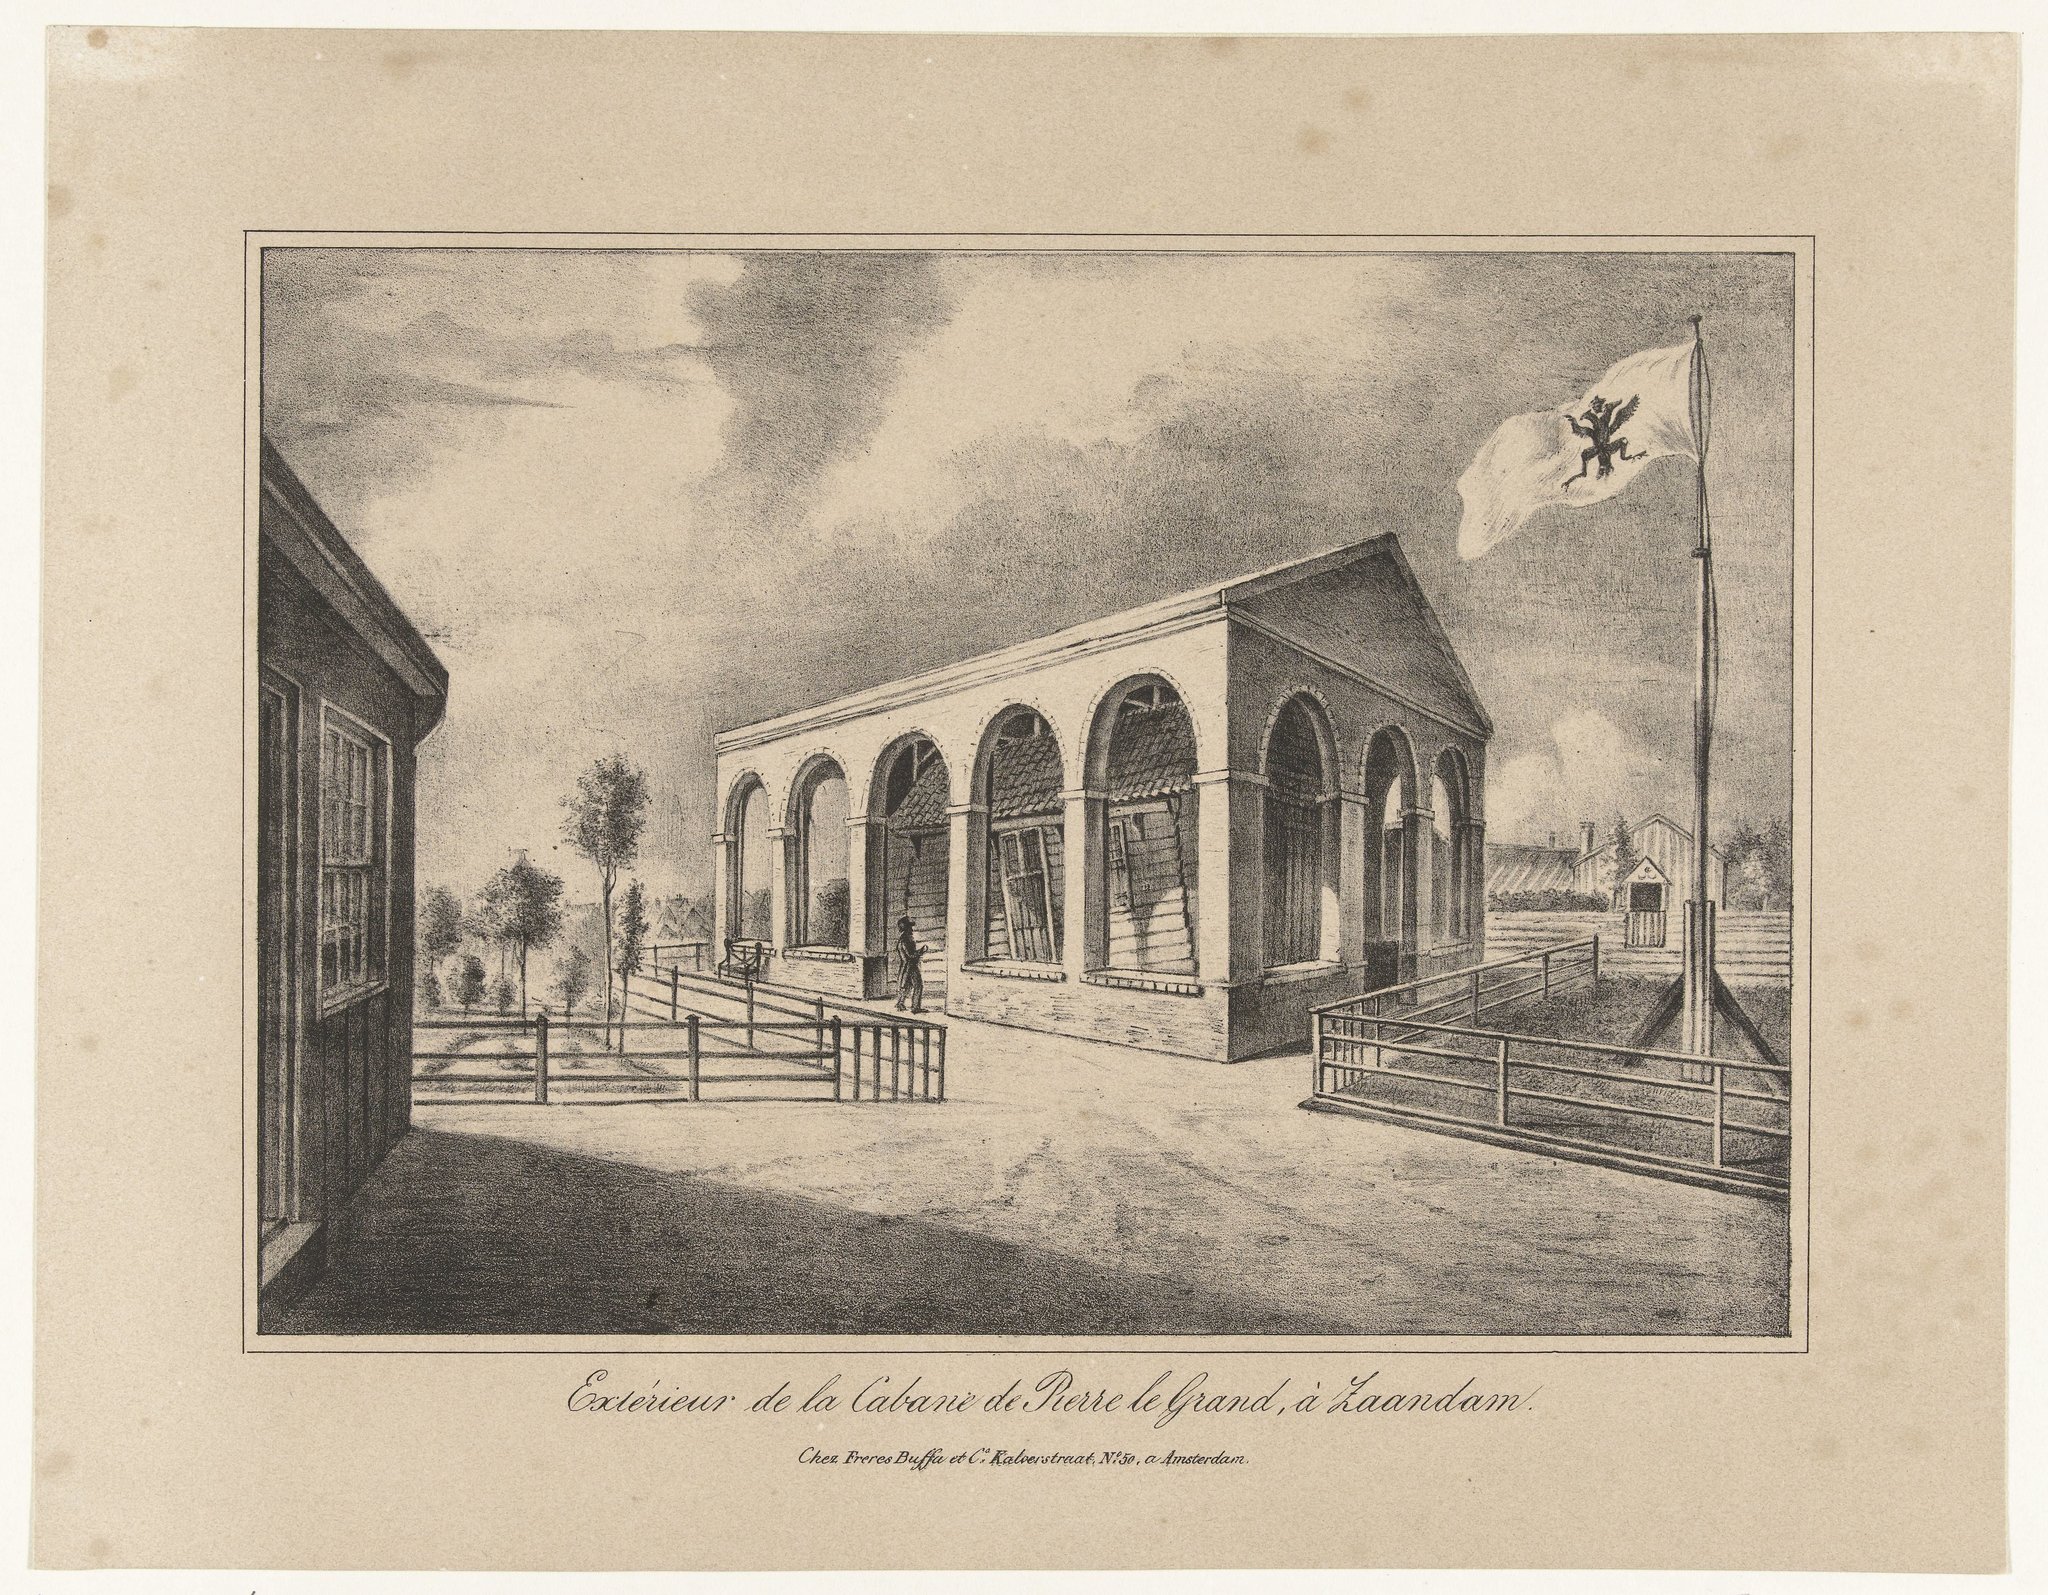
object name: print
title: Het Tsaar Peterhuisje te Zaandam, 1697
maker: Anonymous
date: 1831-1899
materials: paper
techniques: lithograph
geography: amsterdam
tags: peter i de grote (tsaar van rusland)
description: Het Tsaar Peterhuisje te Zaandam, waar tsaar Peter de Grote verbleef in augustus 1697. Met het stenen omhulsel uit 1820, rechts de Russische vlag in de mast.